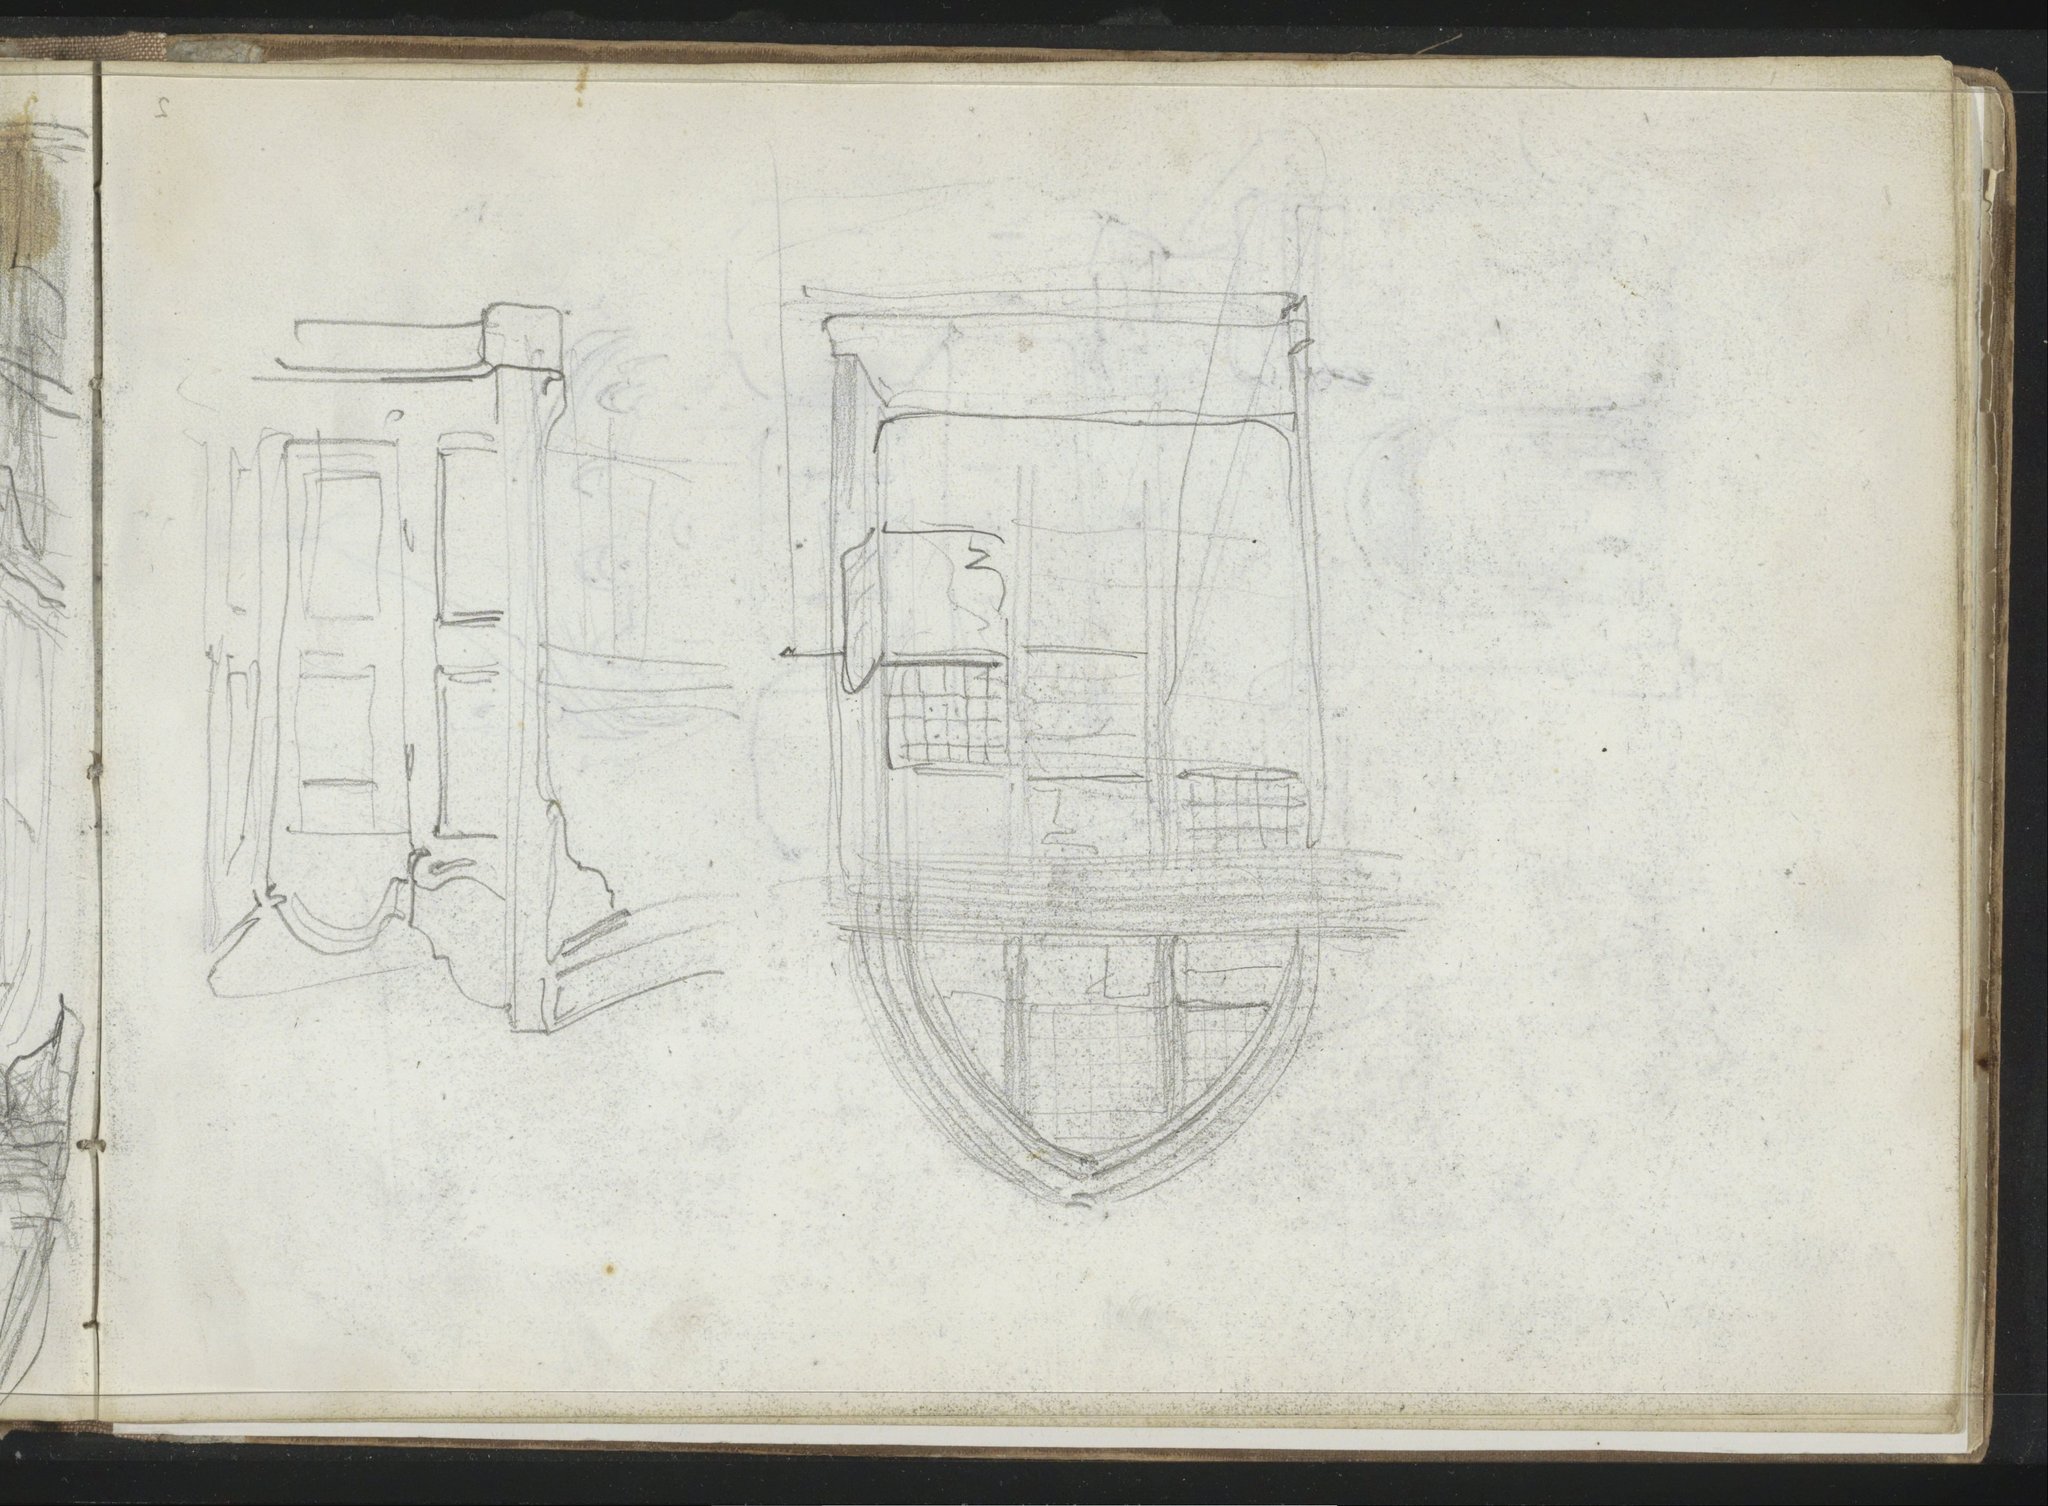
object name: sketchbook leaf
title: Kerkraam en een portaal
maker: johannes bosboom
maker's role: draughtsman, painter, print maker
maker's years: 1817-1891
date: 1827-1891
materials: paper, pencil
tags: church-window, e.g. rose-window, parts of church interior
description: Blad 29 recto uit een schetsboek met 41 pagina's.